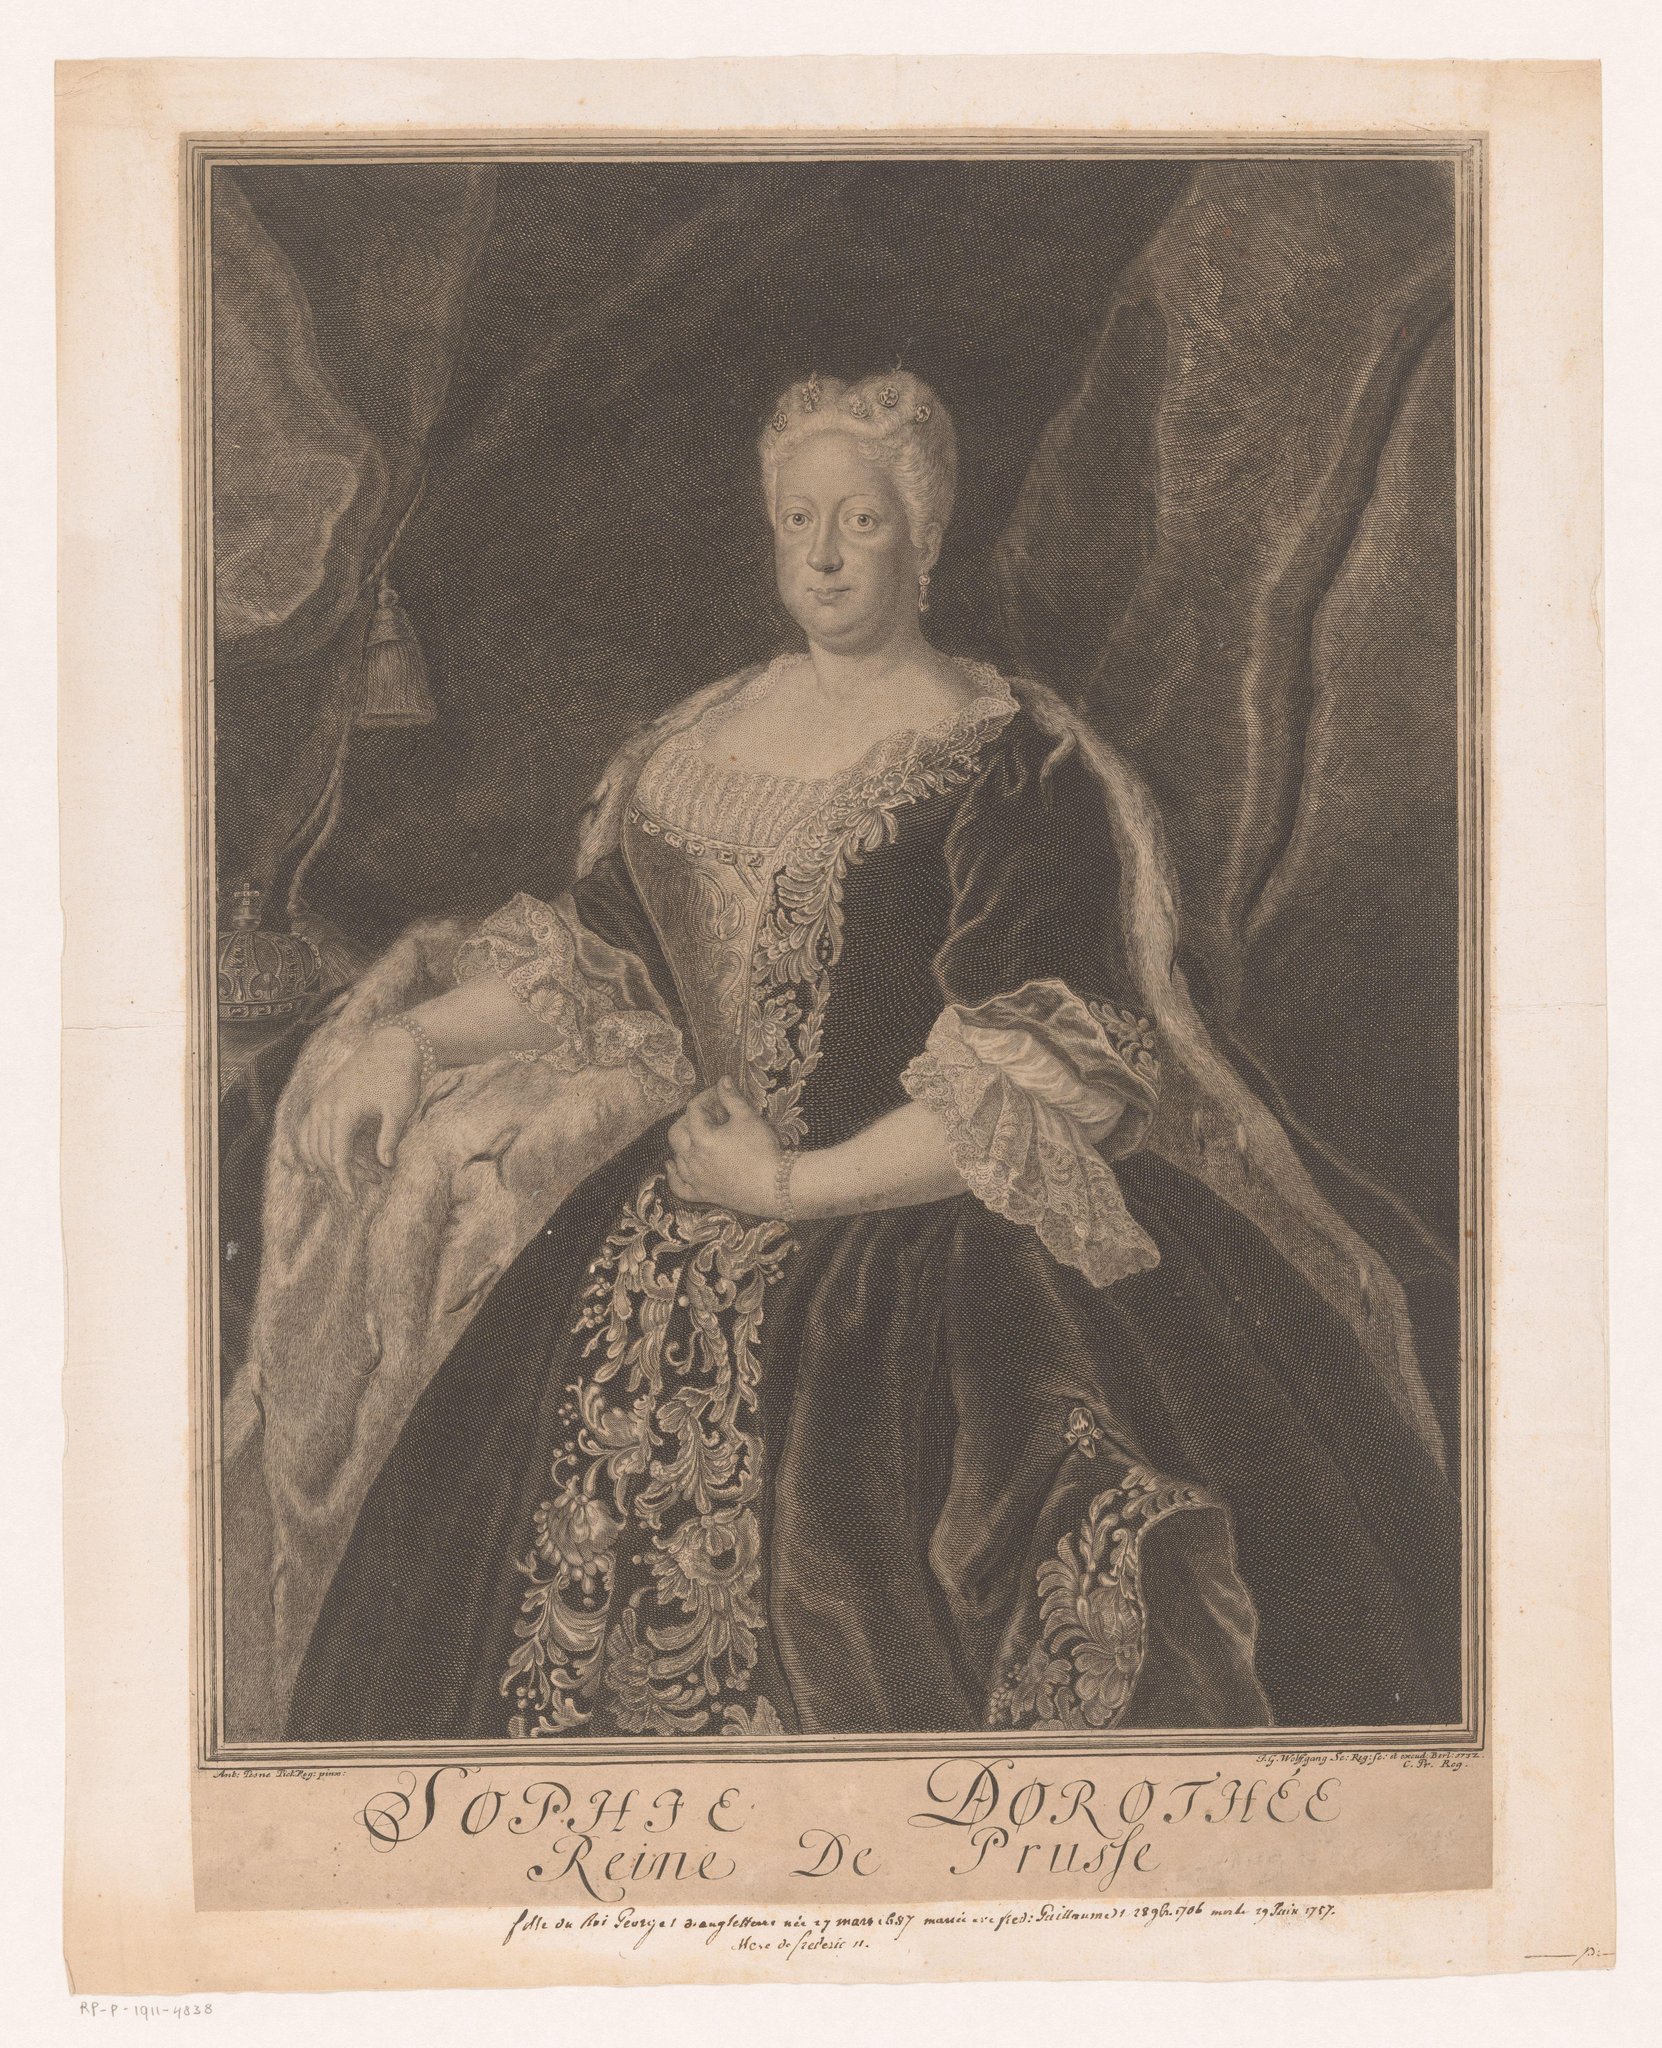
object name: print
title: Portret van Sophia Dorothea van Hannover, koningin van Pruisen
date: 1732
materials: paper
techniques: engraving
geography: berlin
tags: berlin, historical persons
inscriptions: collector's mark: Lugt 2228, inscription: ‘fille du Roi Georges d'anglettere née 27 march 1687 marriée a [...] fied: Guillaume 1 28 [...] 1706 morte 29 Juin 1575. Mere de frederic II.’, collector's mark: Lugt 9, inscription: ‘-p:-’